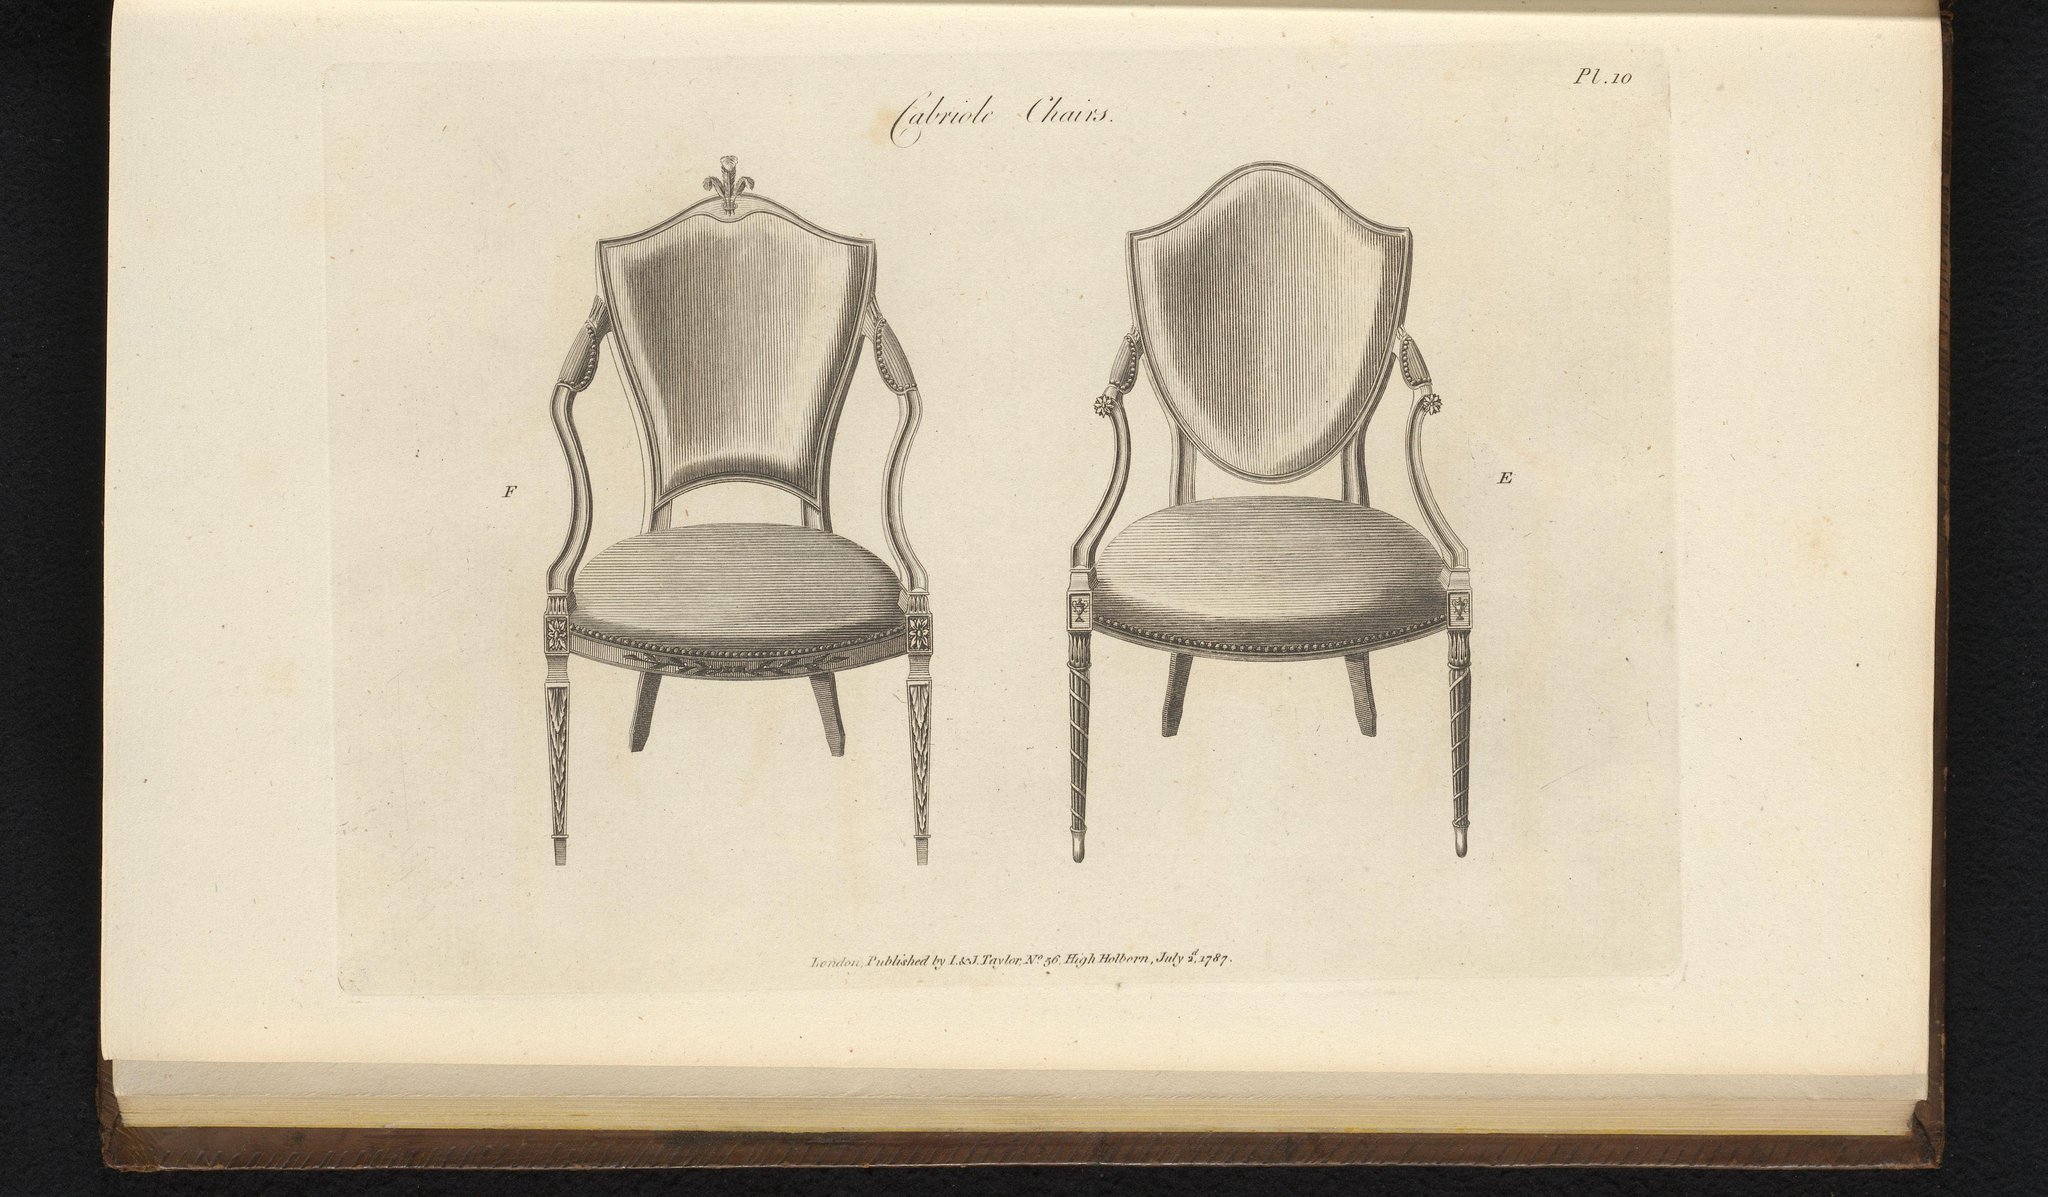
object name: print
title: Twee stoelen met verschillende ornamenten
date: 1787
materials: paper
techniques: engraving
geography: holborn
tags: chair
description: Genummerd: Pl. 10. Stoelen gemerkt: F en E. Prent maakt deel uit van een boek.